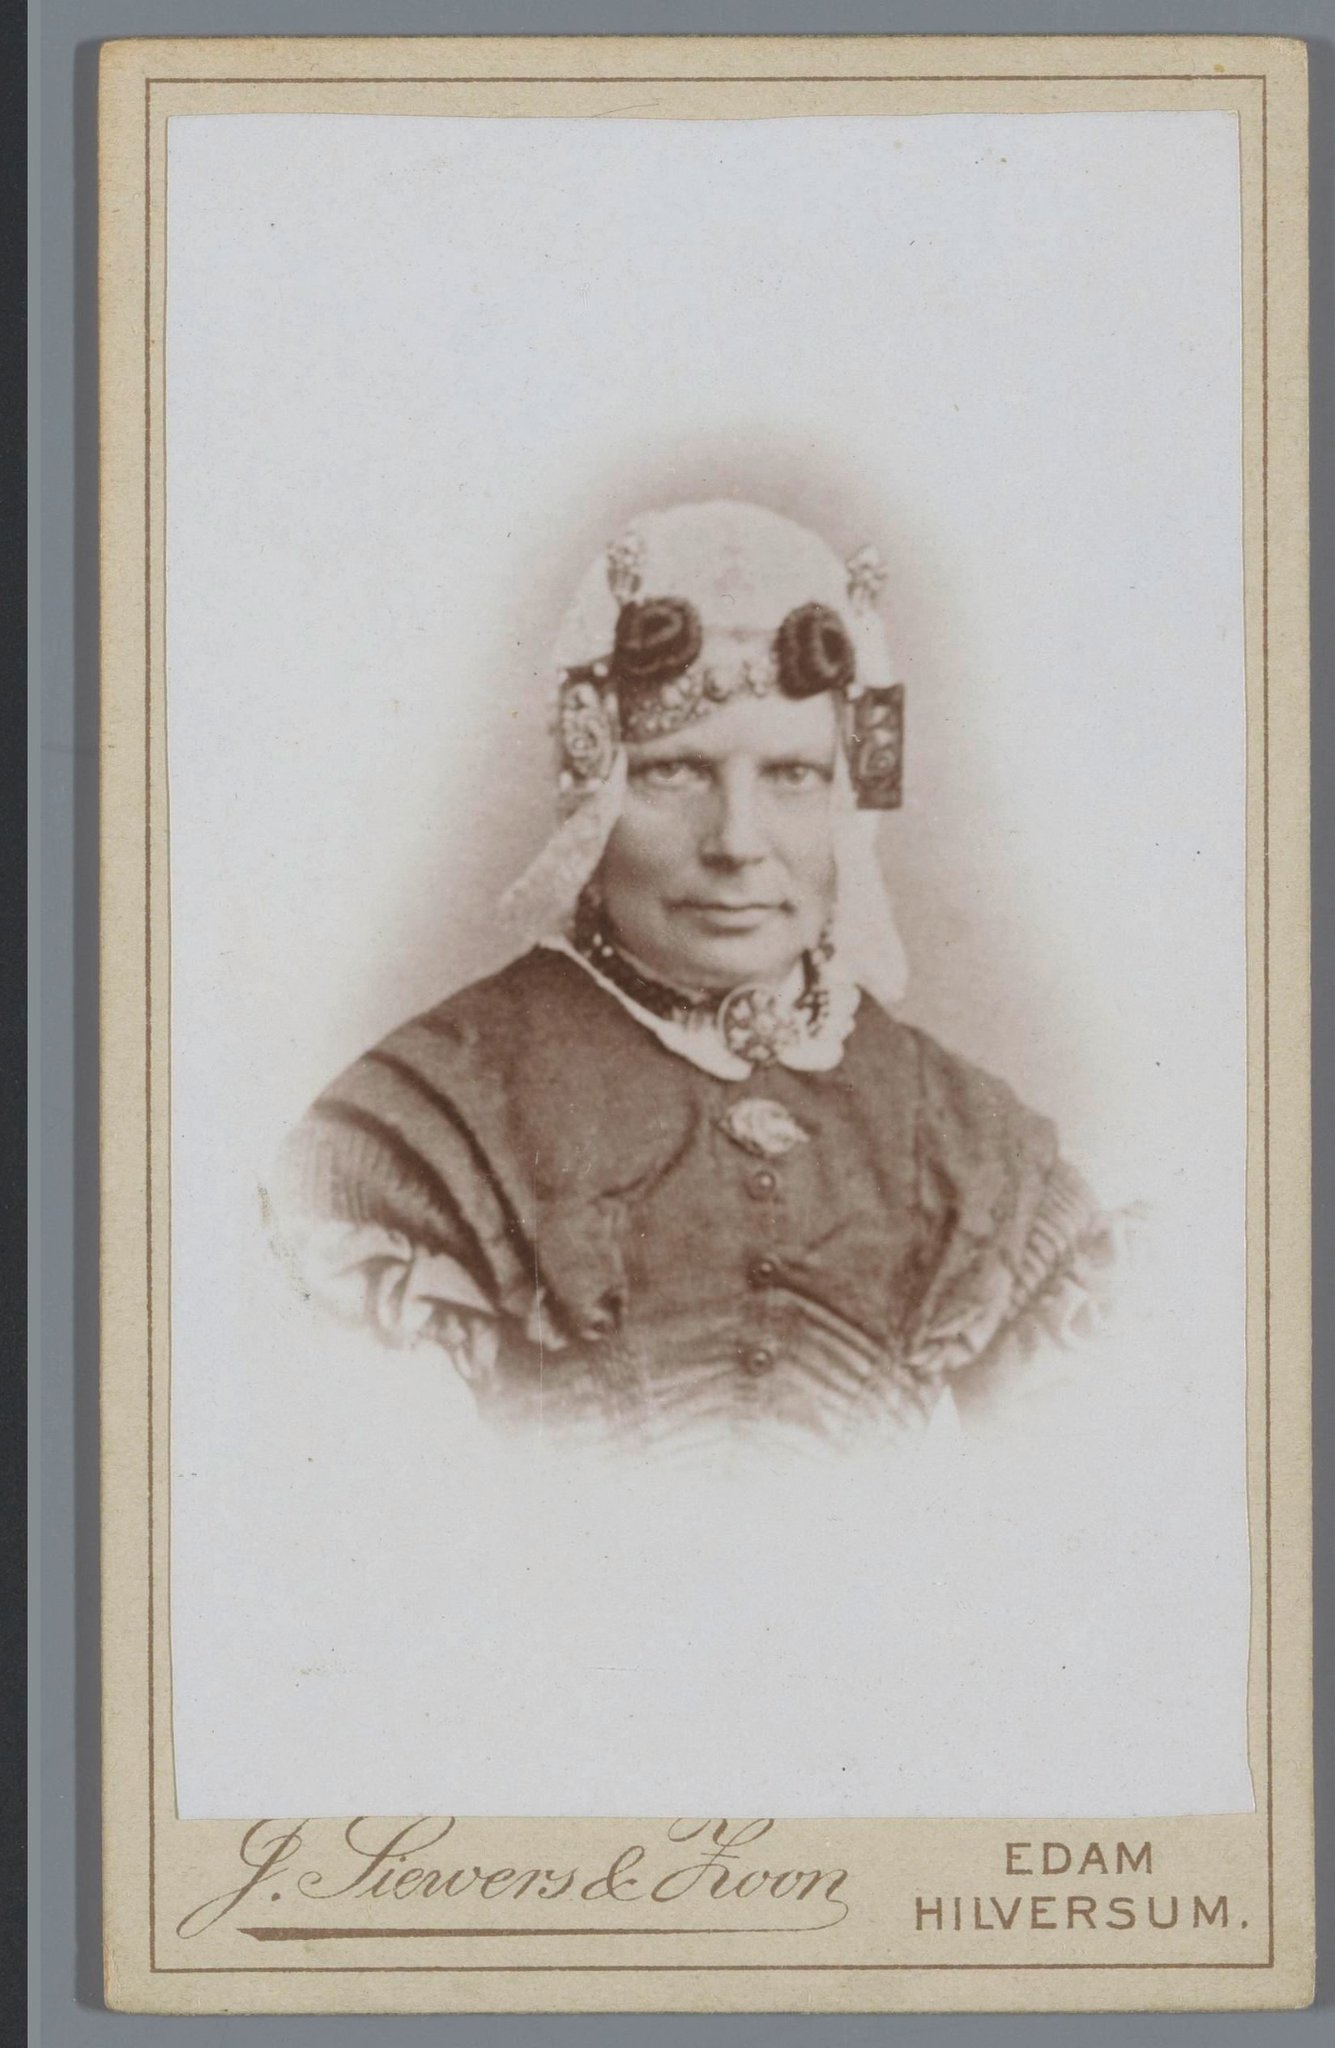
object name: photograph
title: Portret van Hillegond Kramer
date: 1890-1918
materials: cardboard, photographic support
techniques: collodion silver print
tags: historical persons - bb - woman, head-gear: cap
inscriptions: inscription: ‘Photographische/ ATELIERS/ J. Siewers & Zoon/ EDAM/ HILVERSUM./ Specialiteit in vergrootingen.’, inscription: ‘Hillegond Kramer’